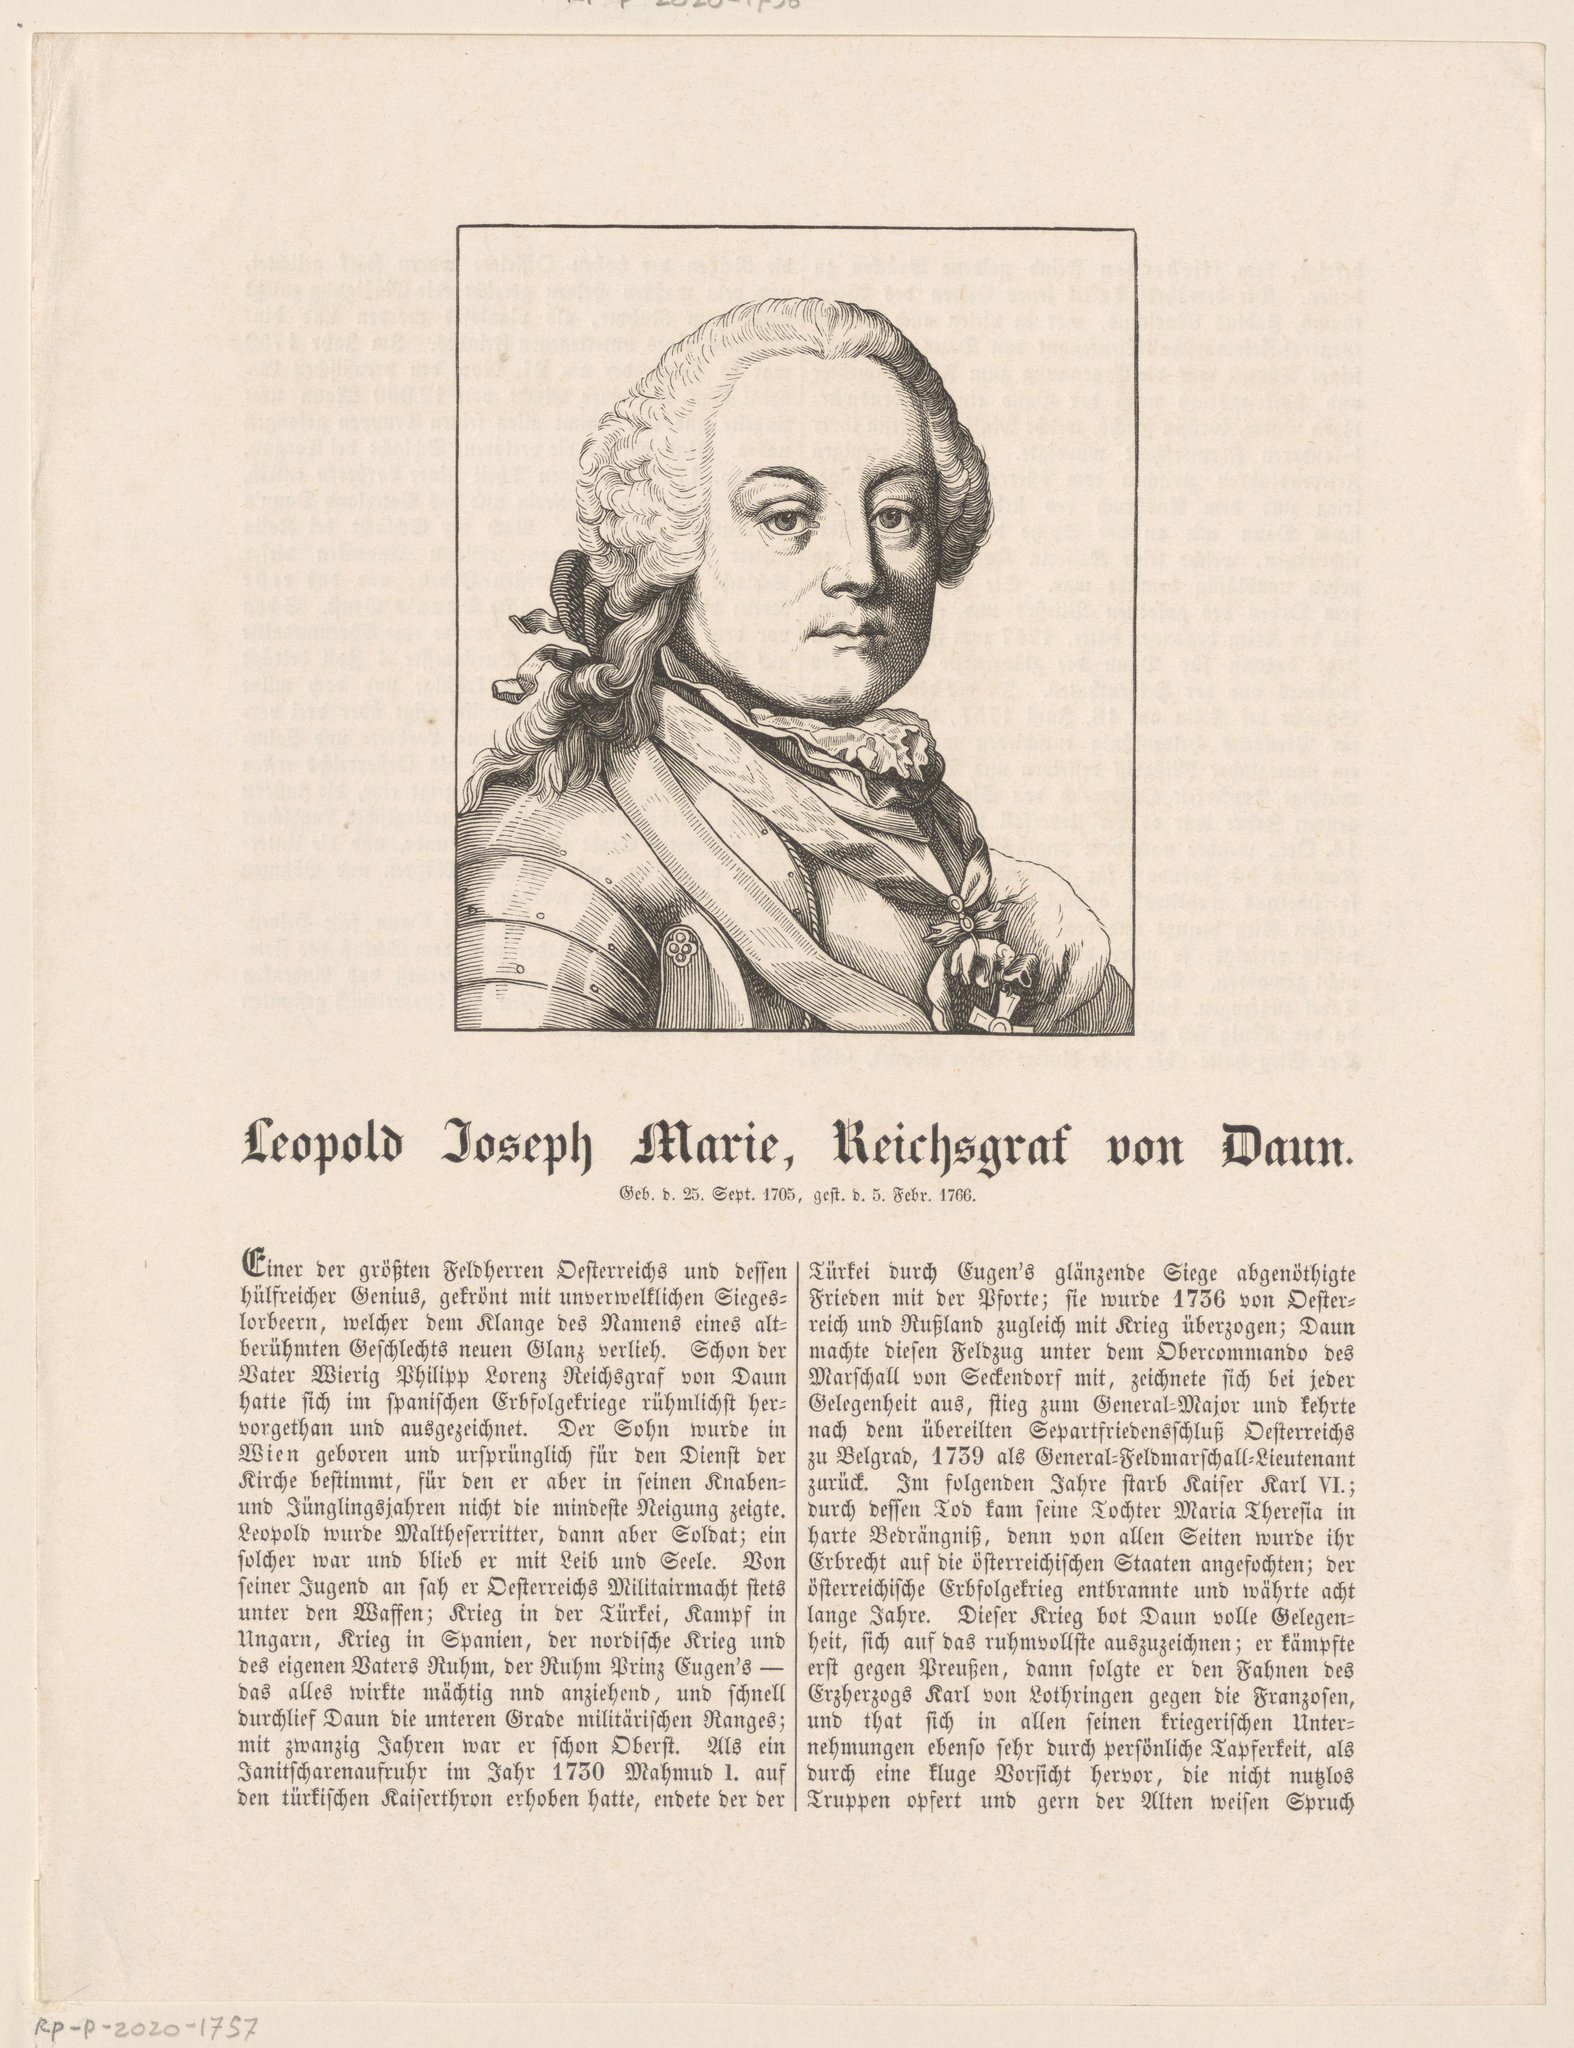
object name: print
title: Portret van Leopold Joseph von Daun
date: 1854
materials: paper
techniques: letterpress printing, engraving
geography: leipzig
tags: vienna, commander-in-chief, general, marshal, historical persons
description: Prent uit: Bechstein, Ludwig. Zweihundert Deutsche Männer In Bildnissen Und Lebensbeschreibungen. Leipzig: Georg Wigand, 1854.